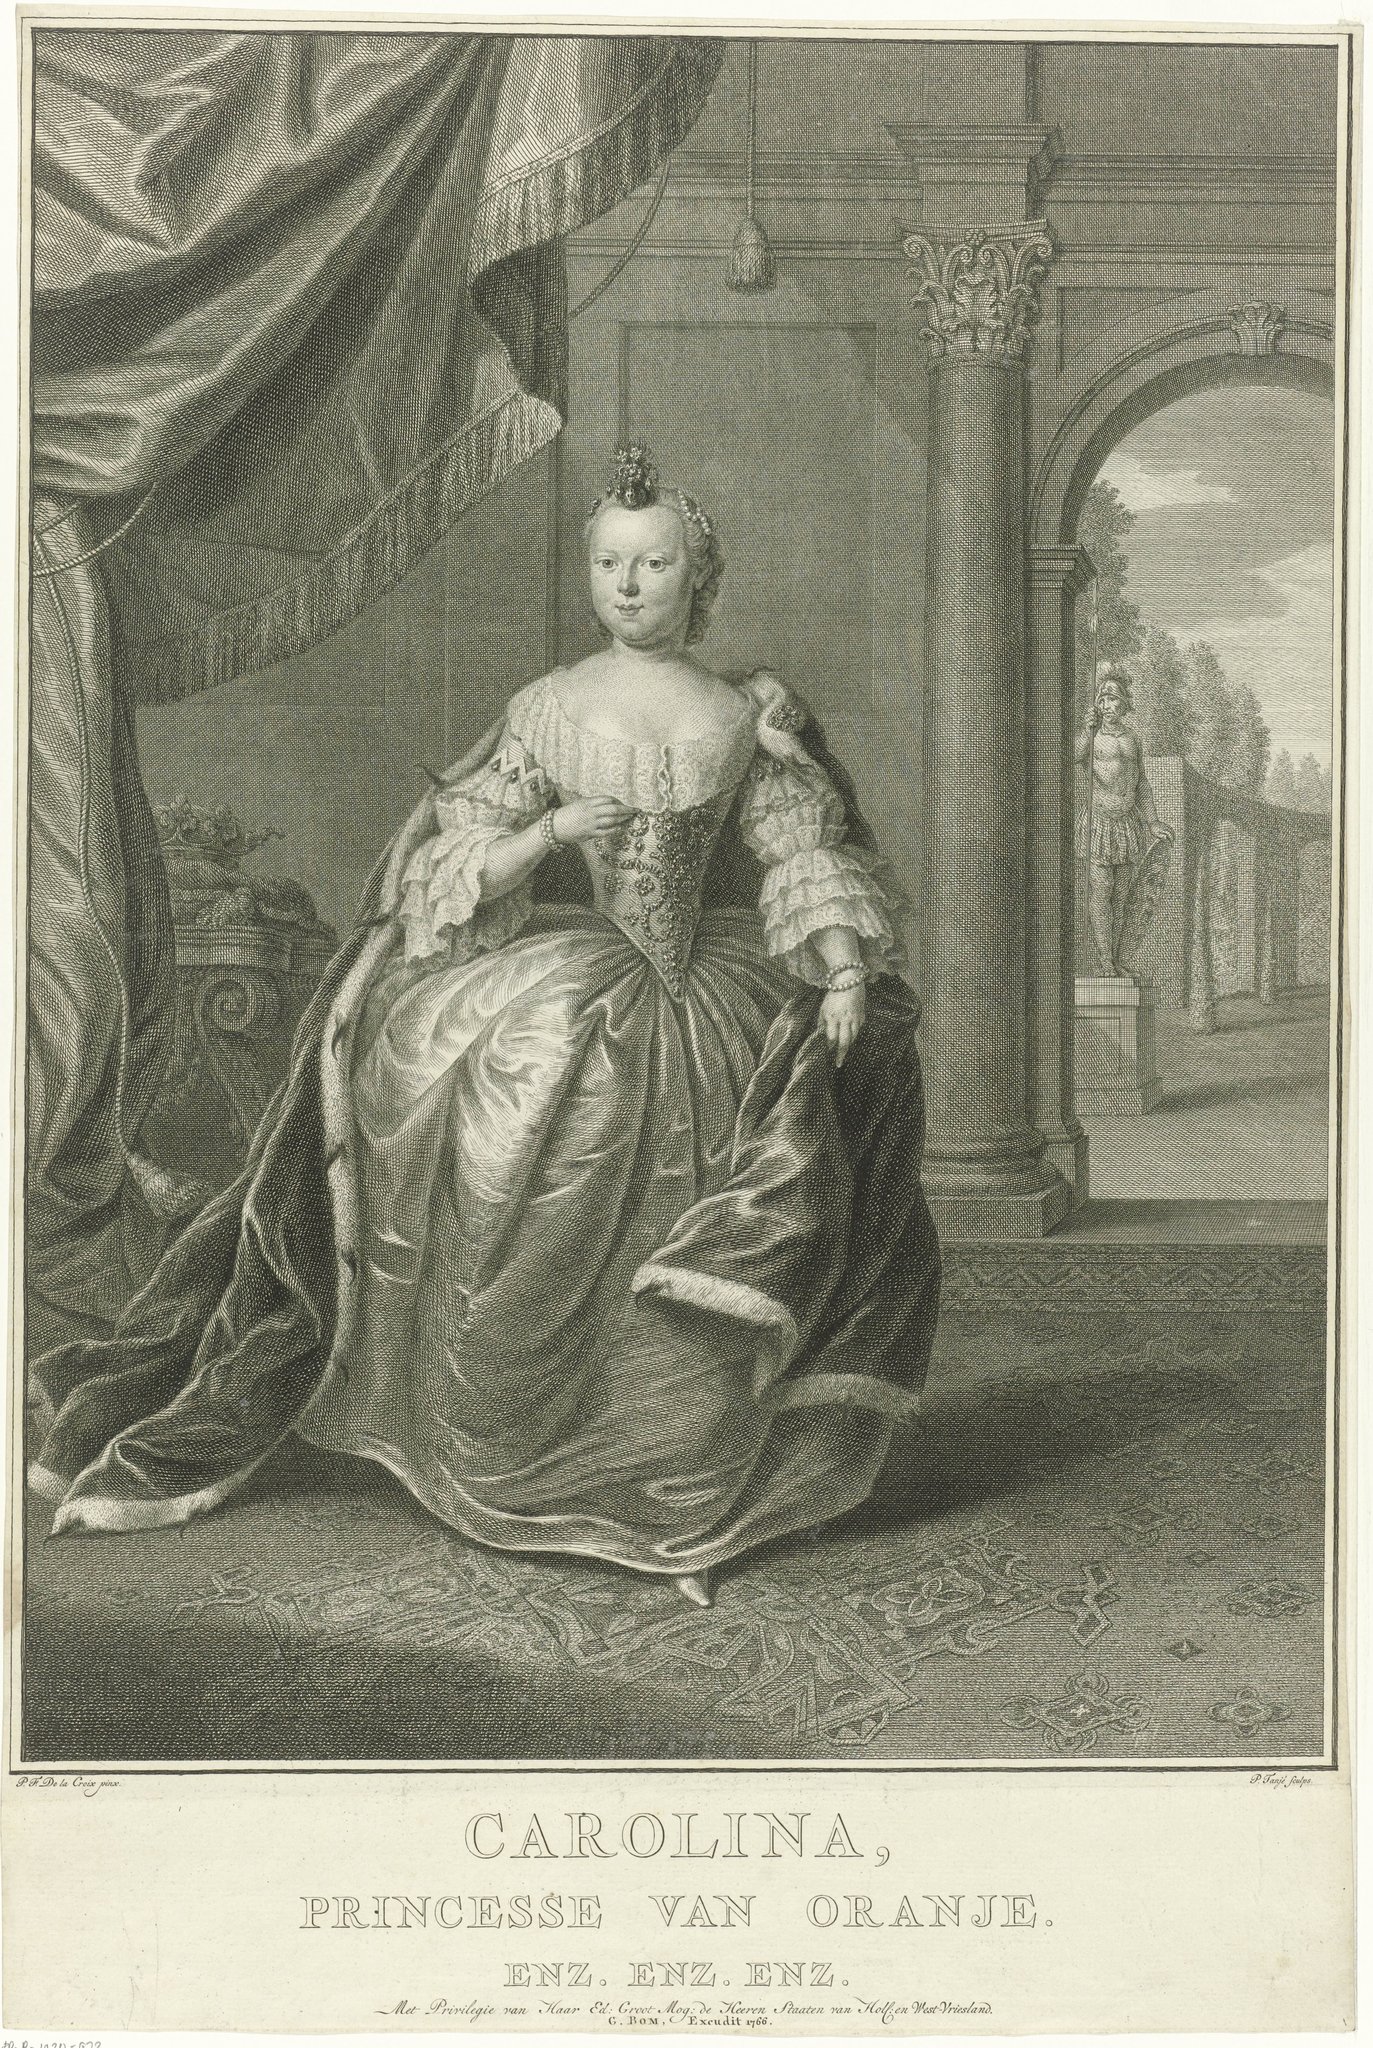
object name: print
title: Portret van Carolina, prinses van Oranje-Nassau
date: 1766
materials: paper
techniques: engraving, etching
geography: amsterdam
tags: carolina (prinses van oranje-nassau), princess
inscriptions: collector's mark: Lugt 2228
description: Portret van Carolina, prinses van Oranje-Nassau, gekleed in een hermelijnen mantel. Op de achtergrond een poort naar een tuin.